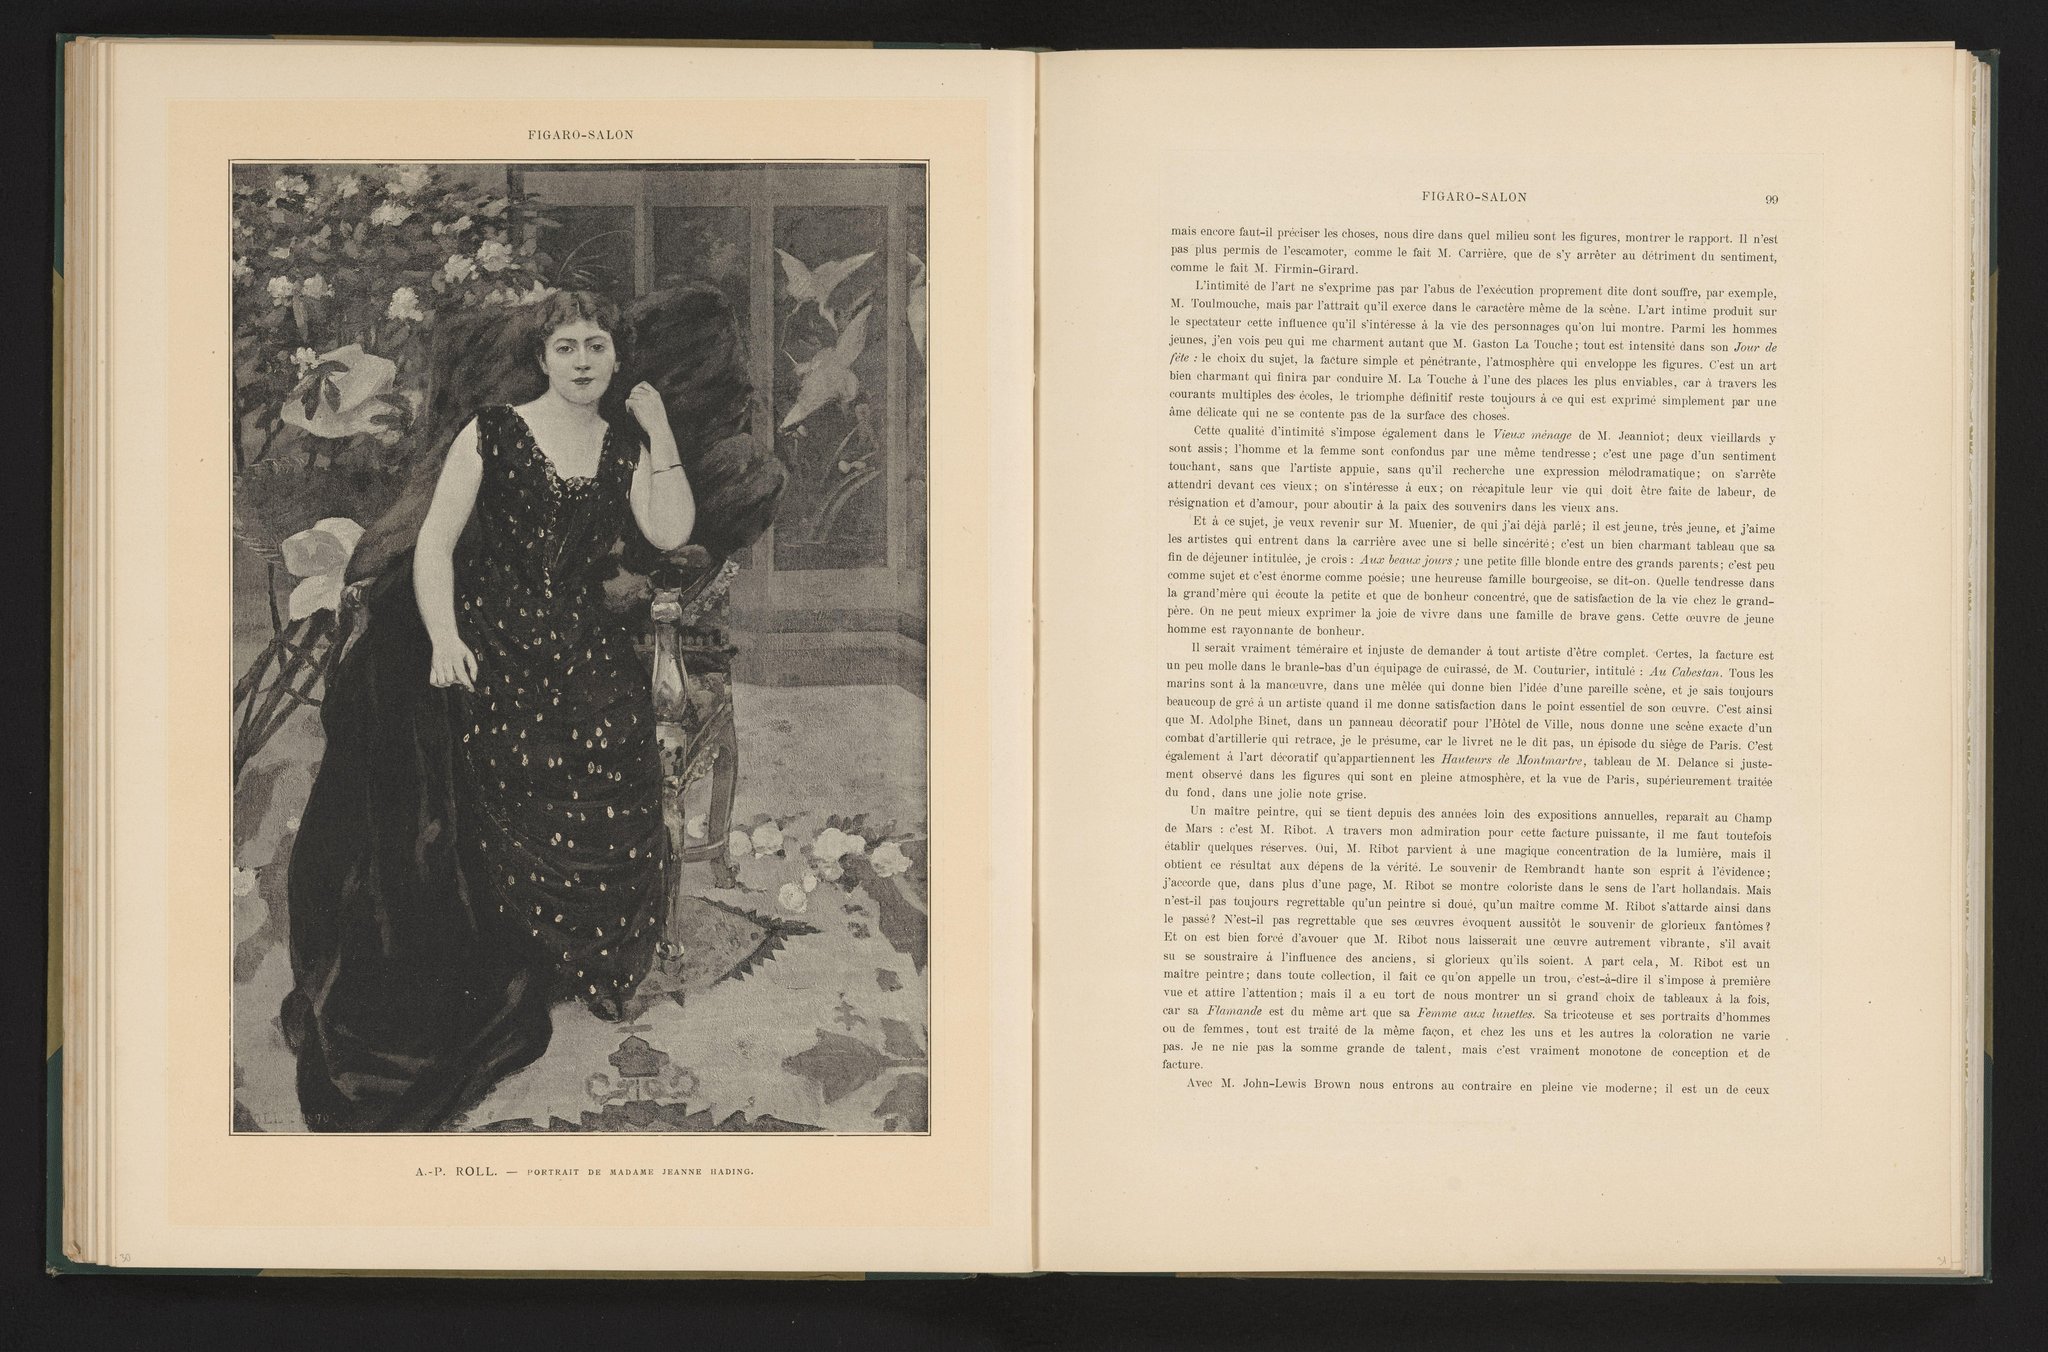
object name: photomechanical print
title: Reproductie van een geschilderd portret van Jane Hading door Alfred Philippe Roll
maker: Anonymous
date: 1885-1901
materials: paper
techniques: autotype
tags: historical persons - bb - woman